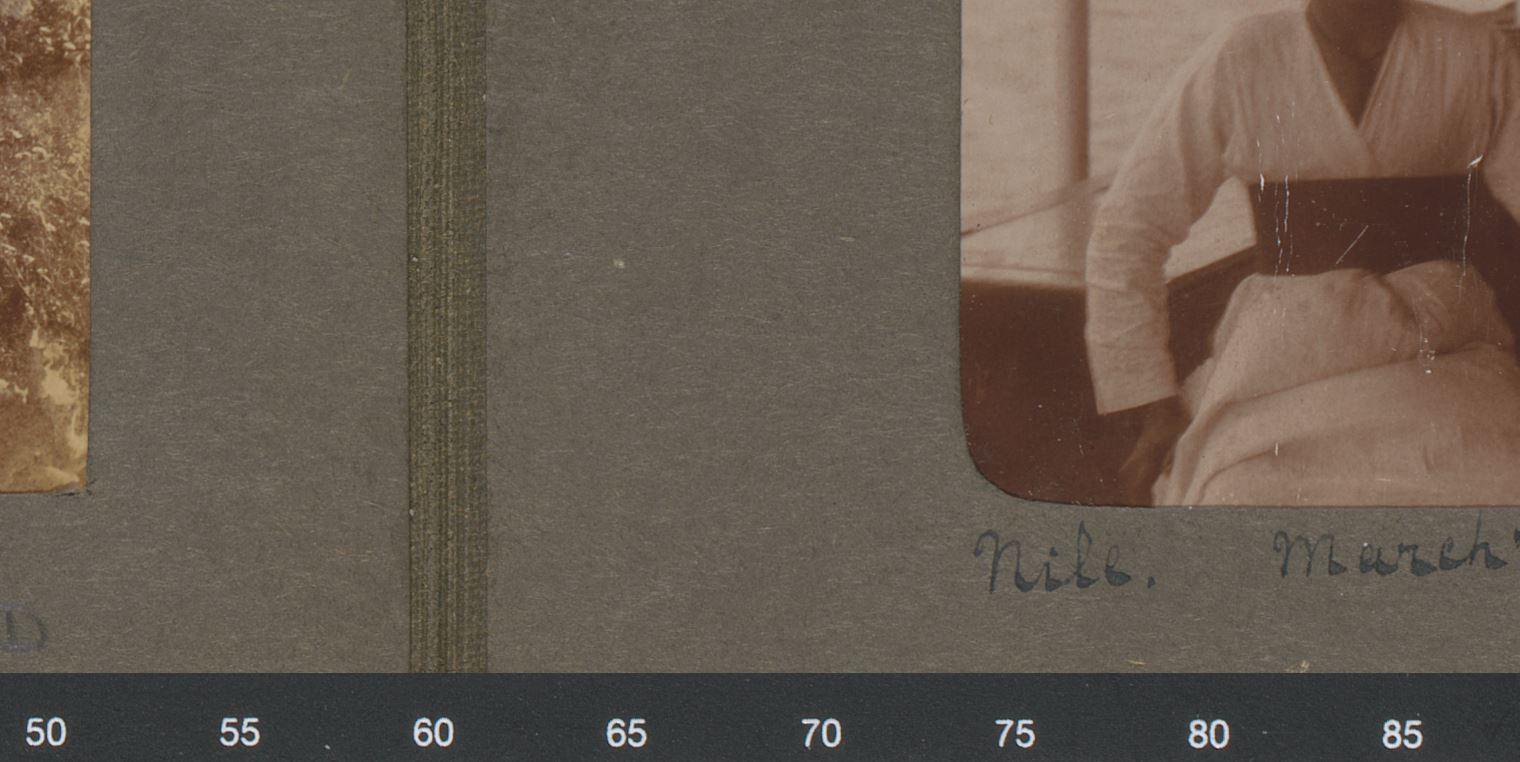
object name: album leaf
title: Portret van een zittende oosterse man, vermoedelijk op een boot op de Nijl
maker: Anonymous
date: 1903-1905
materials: cardboard, paper, photographic support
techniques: collodion silver print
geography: nile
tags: adult man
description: Onderdeel van Reisalbum van een Nederlandse familie met bezienswaardigheden in Europa, Egypte en New York.